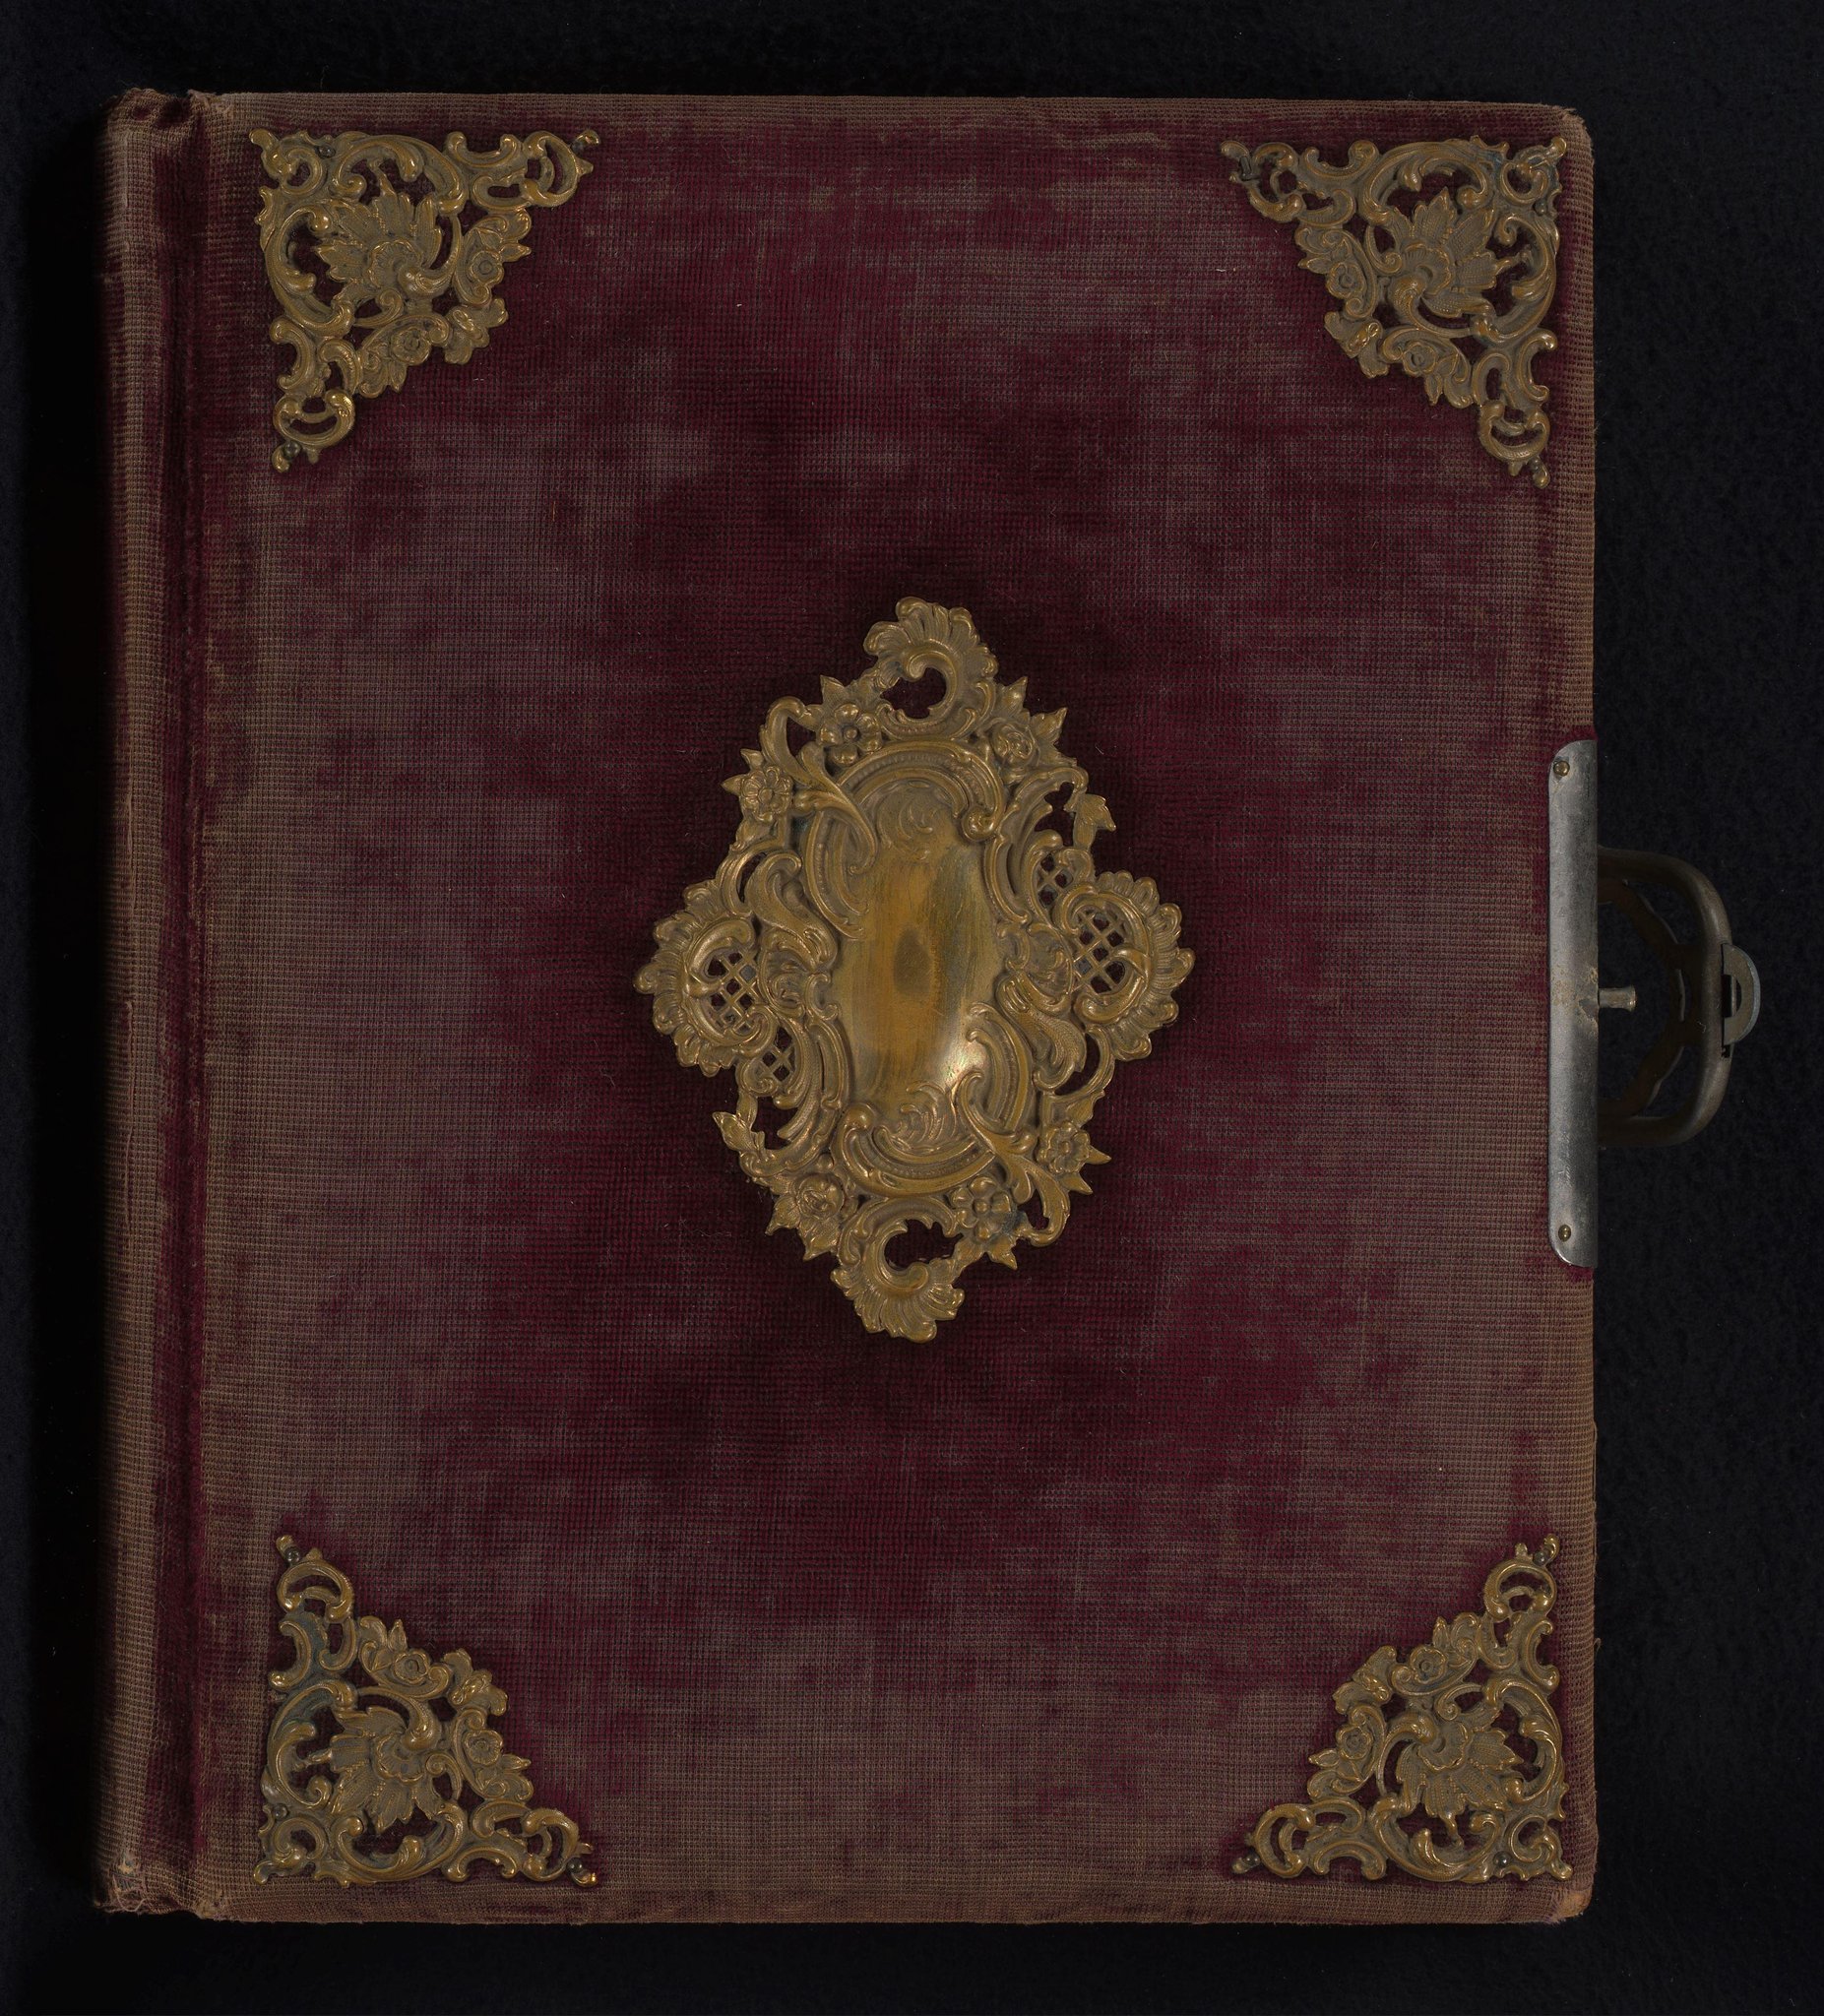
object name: musical box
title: Fotoalbum met speeldoos (leeg)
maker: Anonymous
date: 1860-1900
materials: cardboard, glass, metal, paper, textile, wood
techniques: color on snow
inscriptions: collector's mark: ‘DIENST/ VERSPREIDE/ RIJKSKOLLEKTIES/ (...) A 654’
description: Fotoalbum met speeldoos met zestien pagina's met op iedere pagina ofwel een met gouden lijnen omkaderde passe-partout voor een kabinetfoto, ofwel vier met gouden lijnen omkaderde passe-partouts voor cartes-de-visite. In totaal is er in het album ruimte voor zes kabinetfoto's en veertig cartes-de-visite.